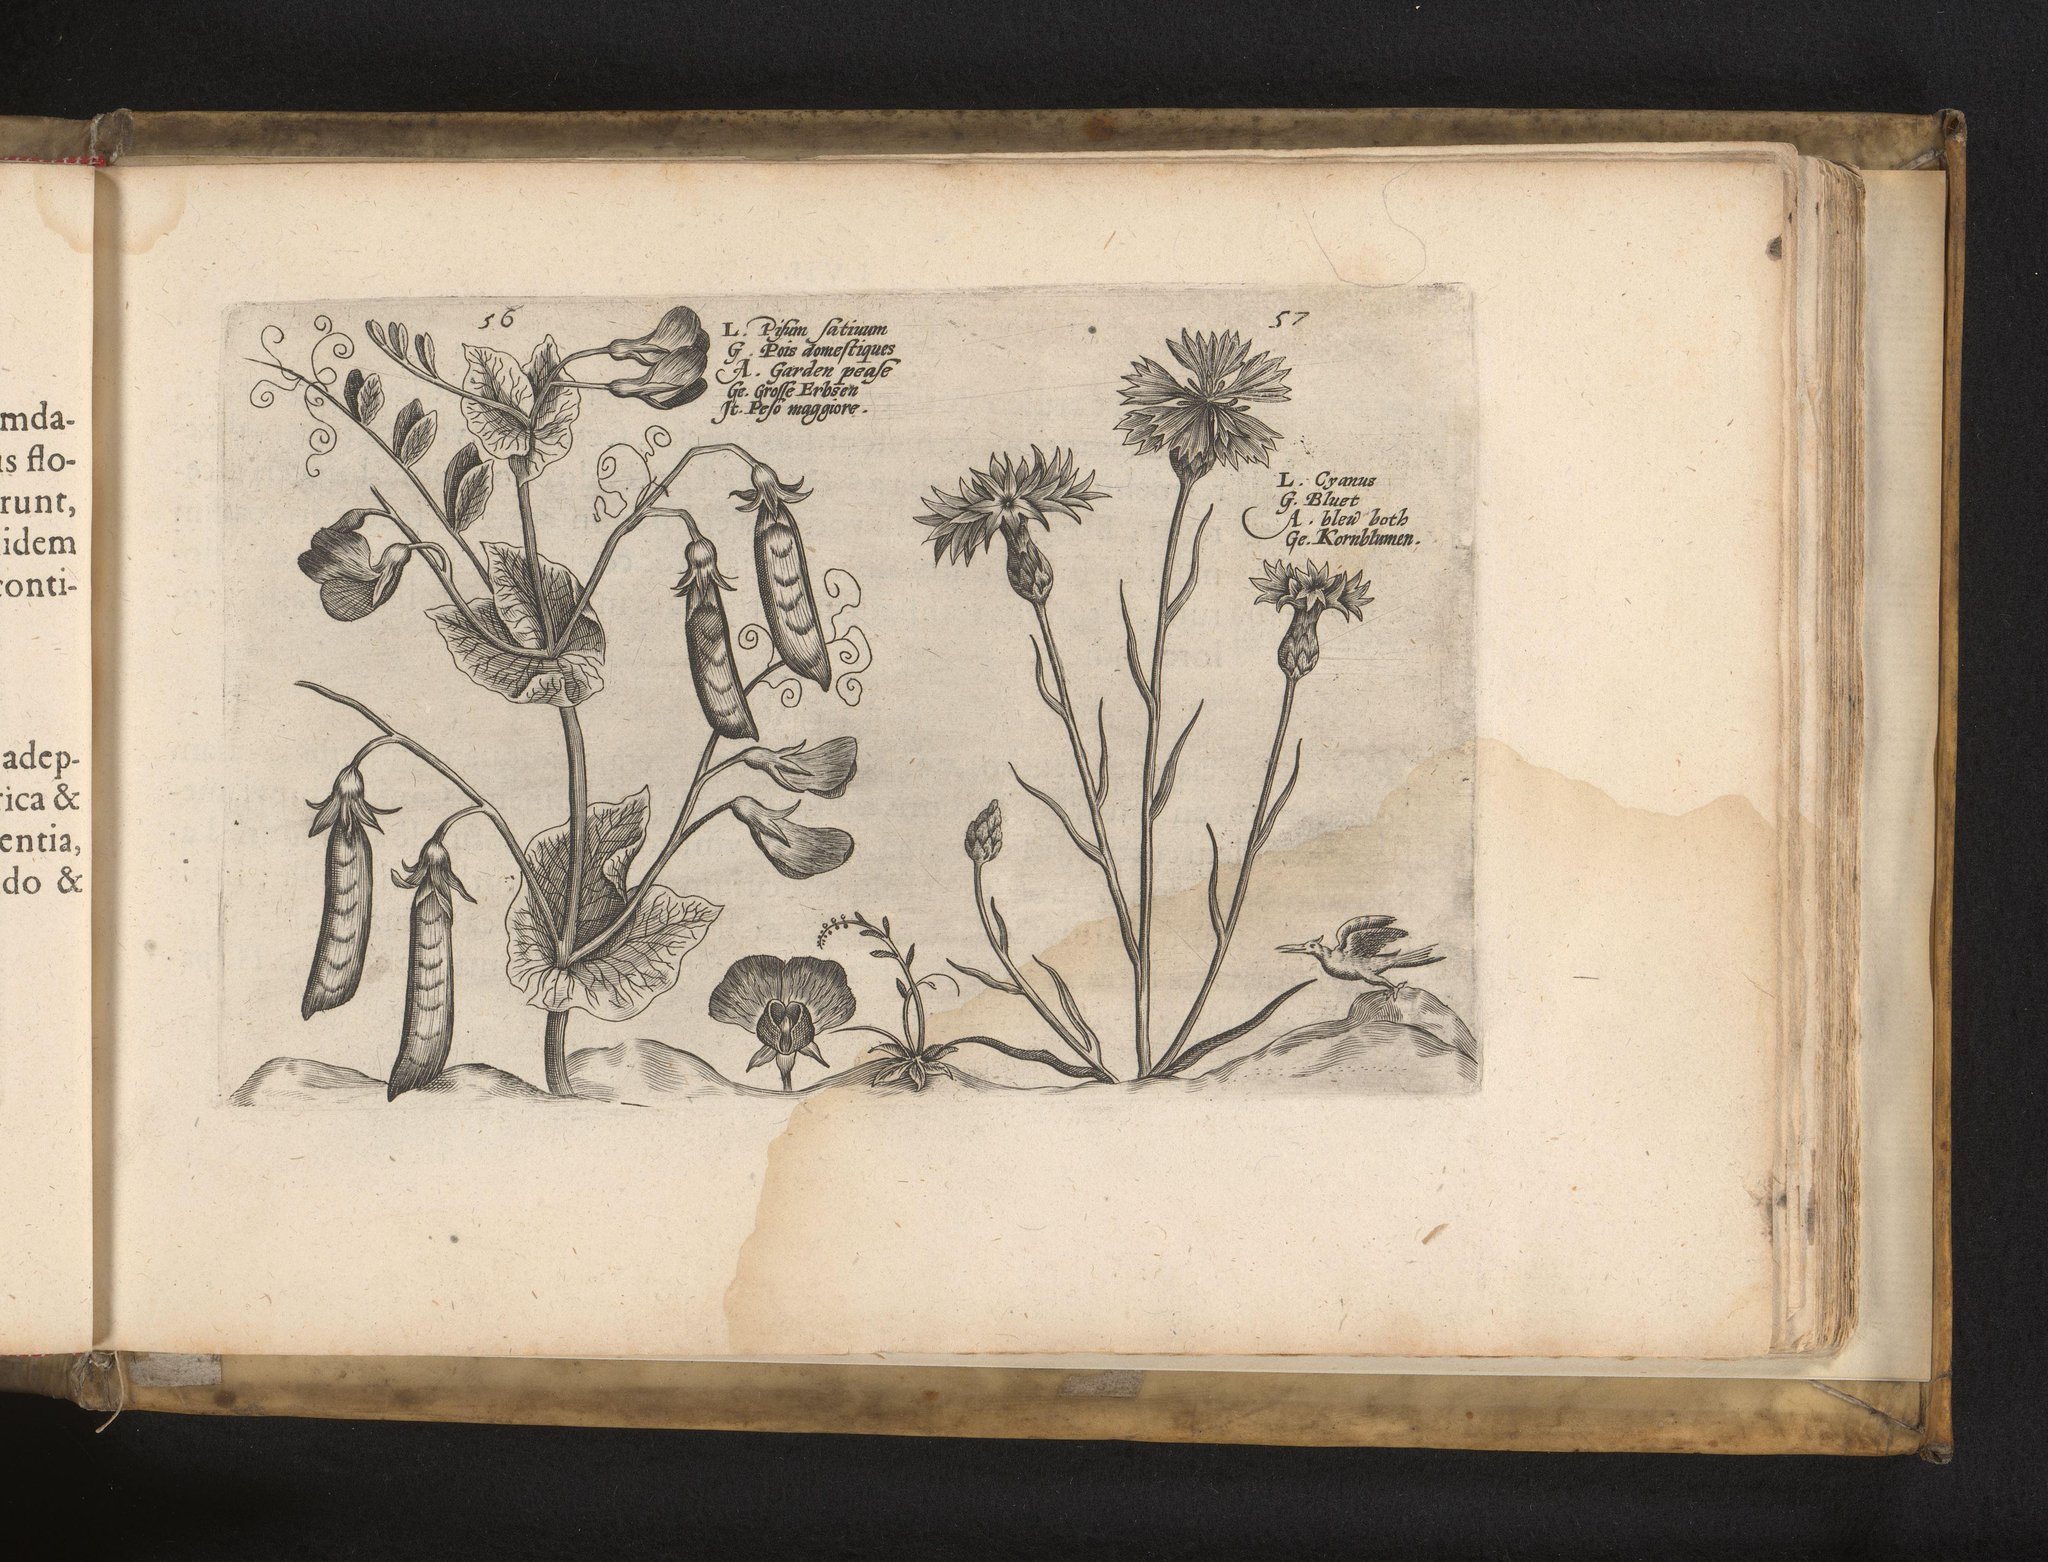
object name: book illustration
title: Cyanus / Bluet / Blew both / Kornblumen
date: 1617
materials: paper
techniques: engraving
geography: arnhem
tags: flowers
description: Prent uit: Passe, Crispijn van de (II). Hortus floridus in quo rariorum & minus vulgarium florum icones ad vivam veramque formam. Arnhem: Johannes Janssonius, 1617.